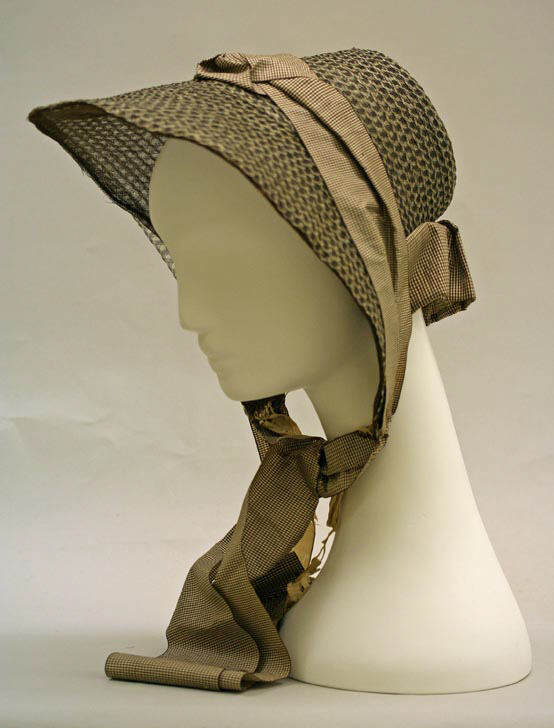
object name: poke bonnet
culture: american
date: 1860